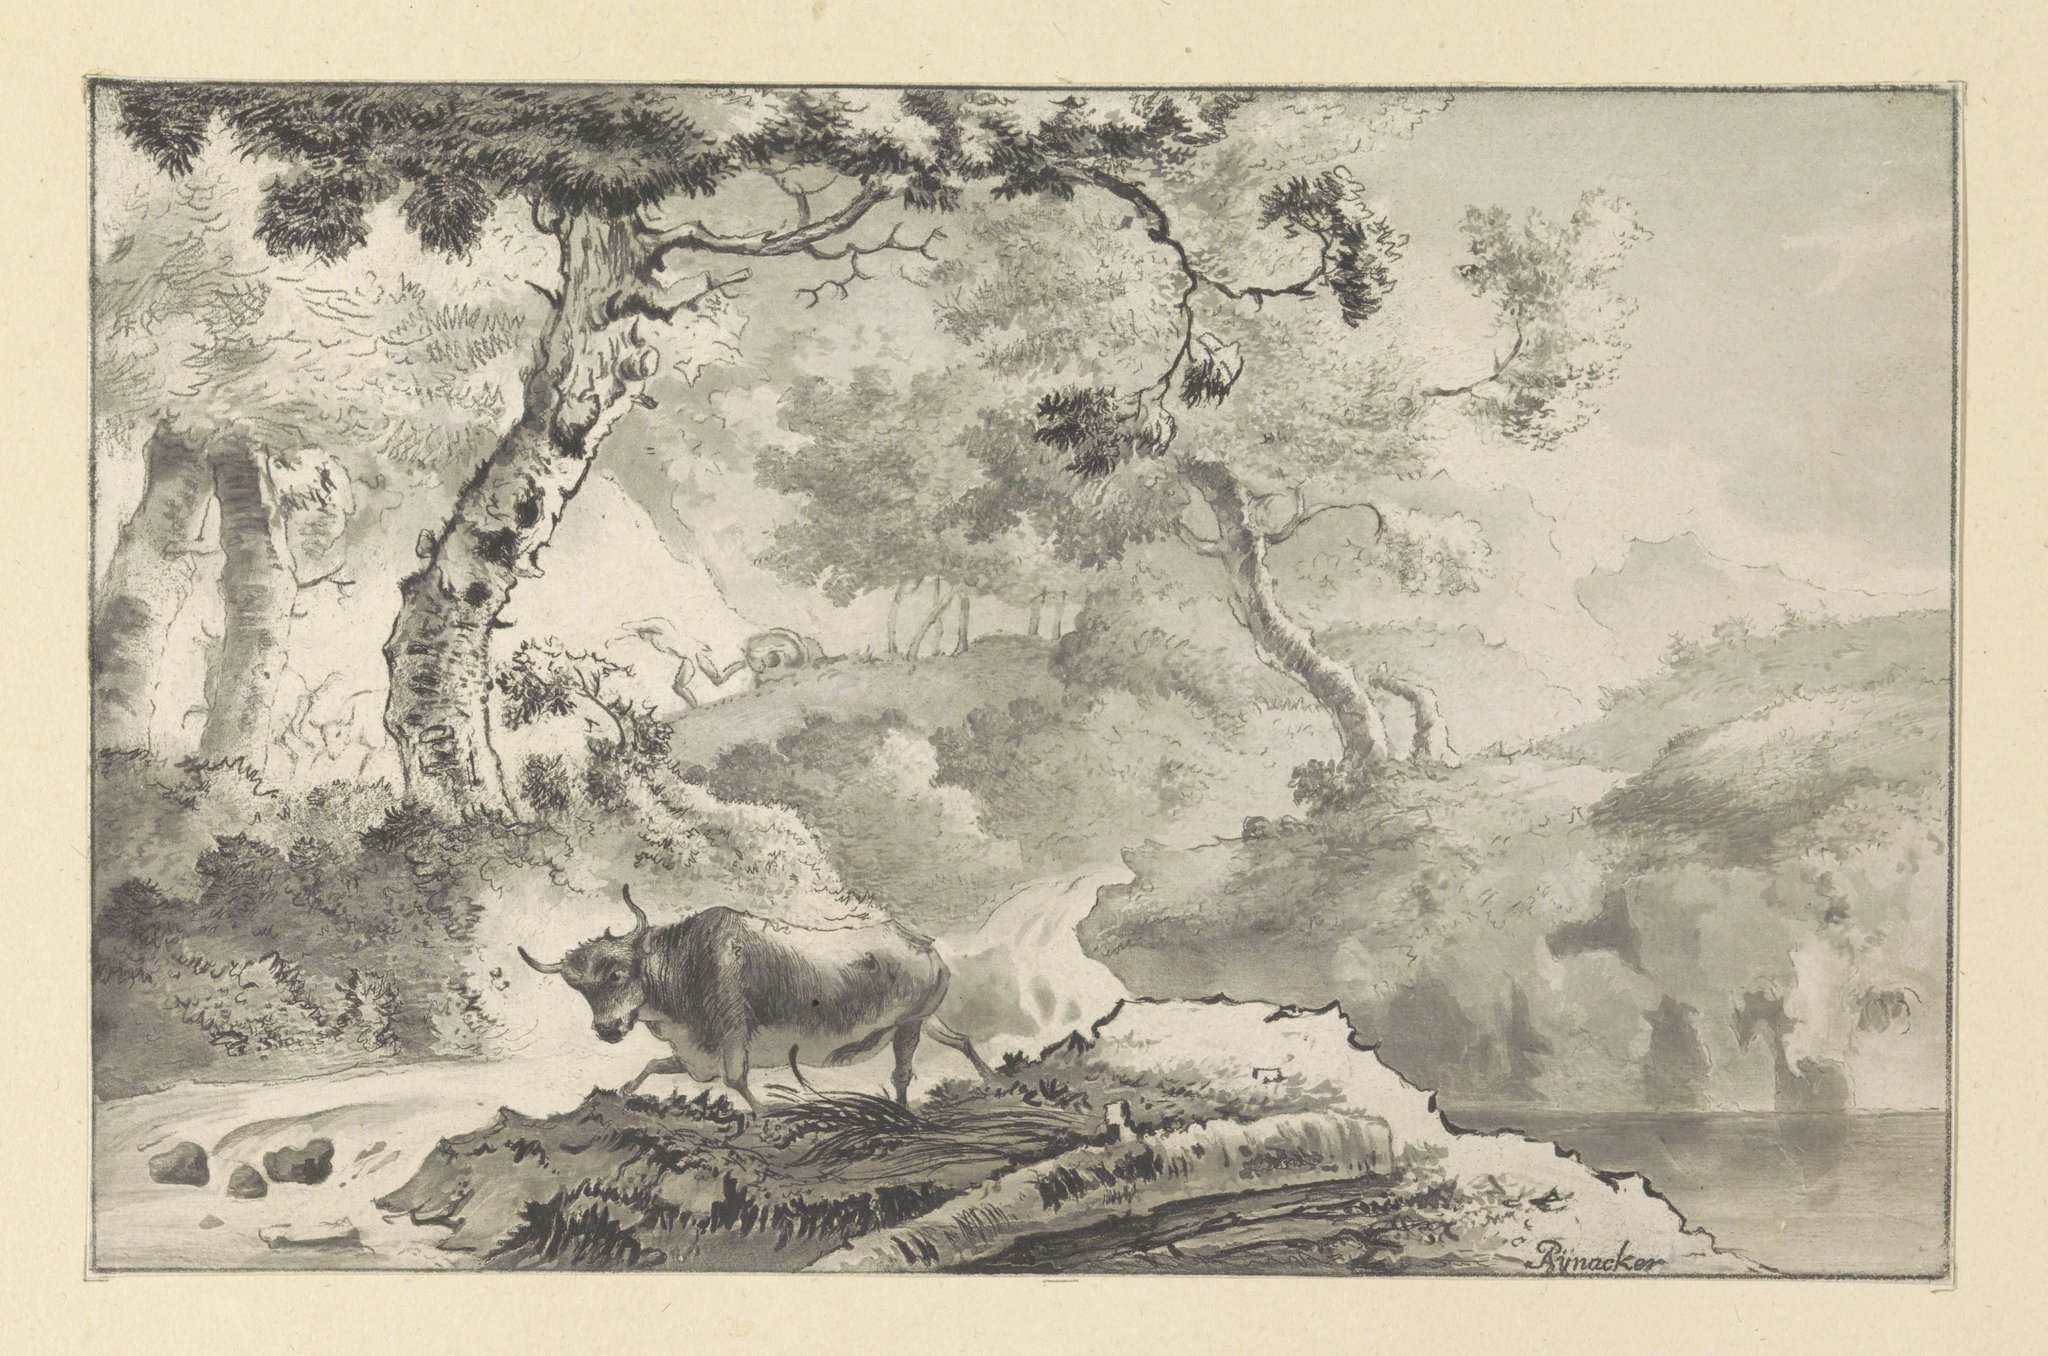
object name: print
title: Boslandschap met dier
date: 1795-1821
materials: paper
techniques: etching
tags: bull, landscapes (+ landscape with figures, staffage)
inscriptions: collector's mark: Lugt 2228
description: De voltooide prent werd opgenomen in: Collection d'imitations de dessins d'après les principaux maîtres hollandais et flamands, Londen, C. Josi, 1821.